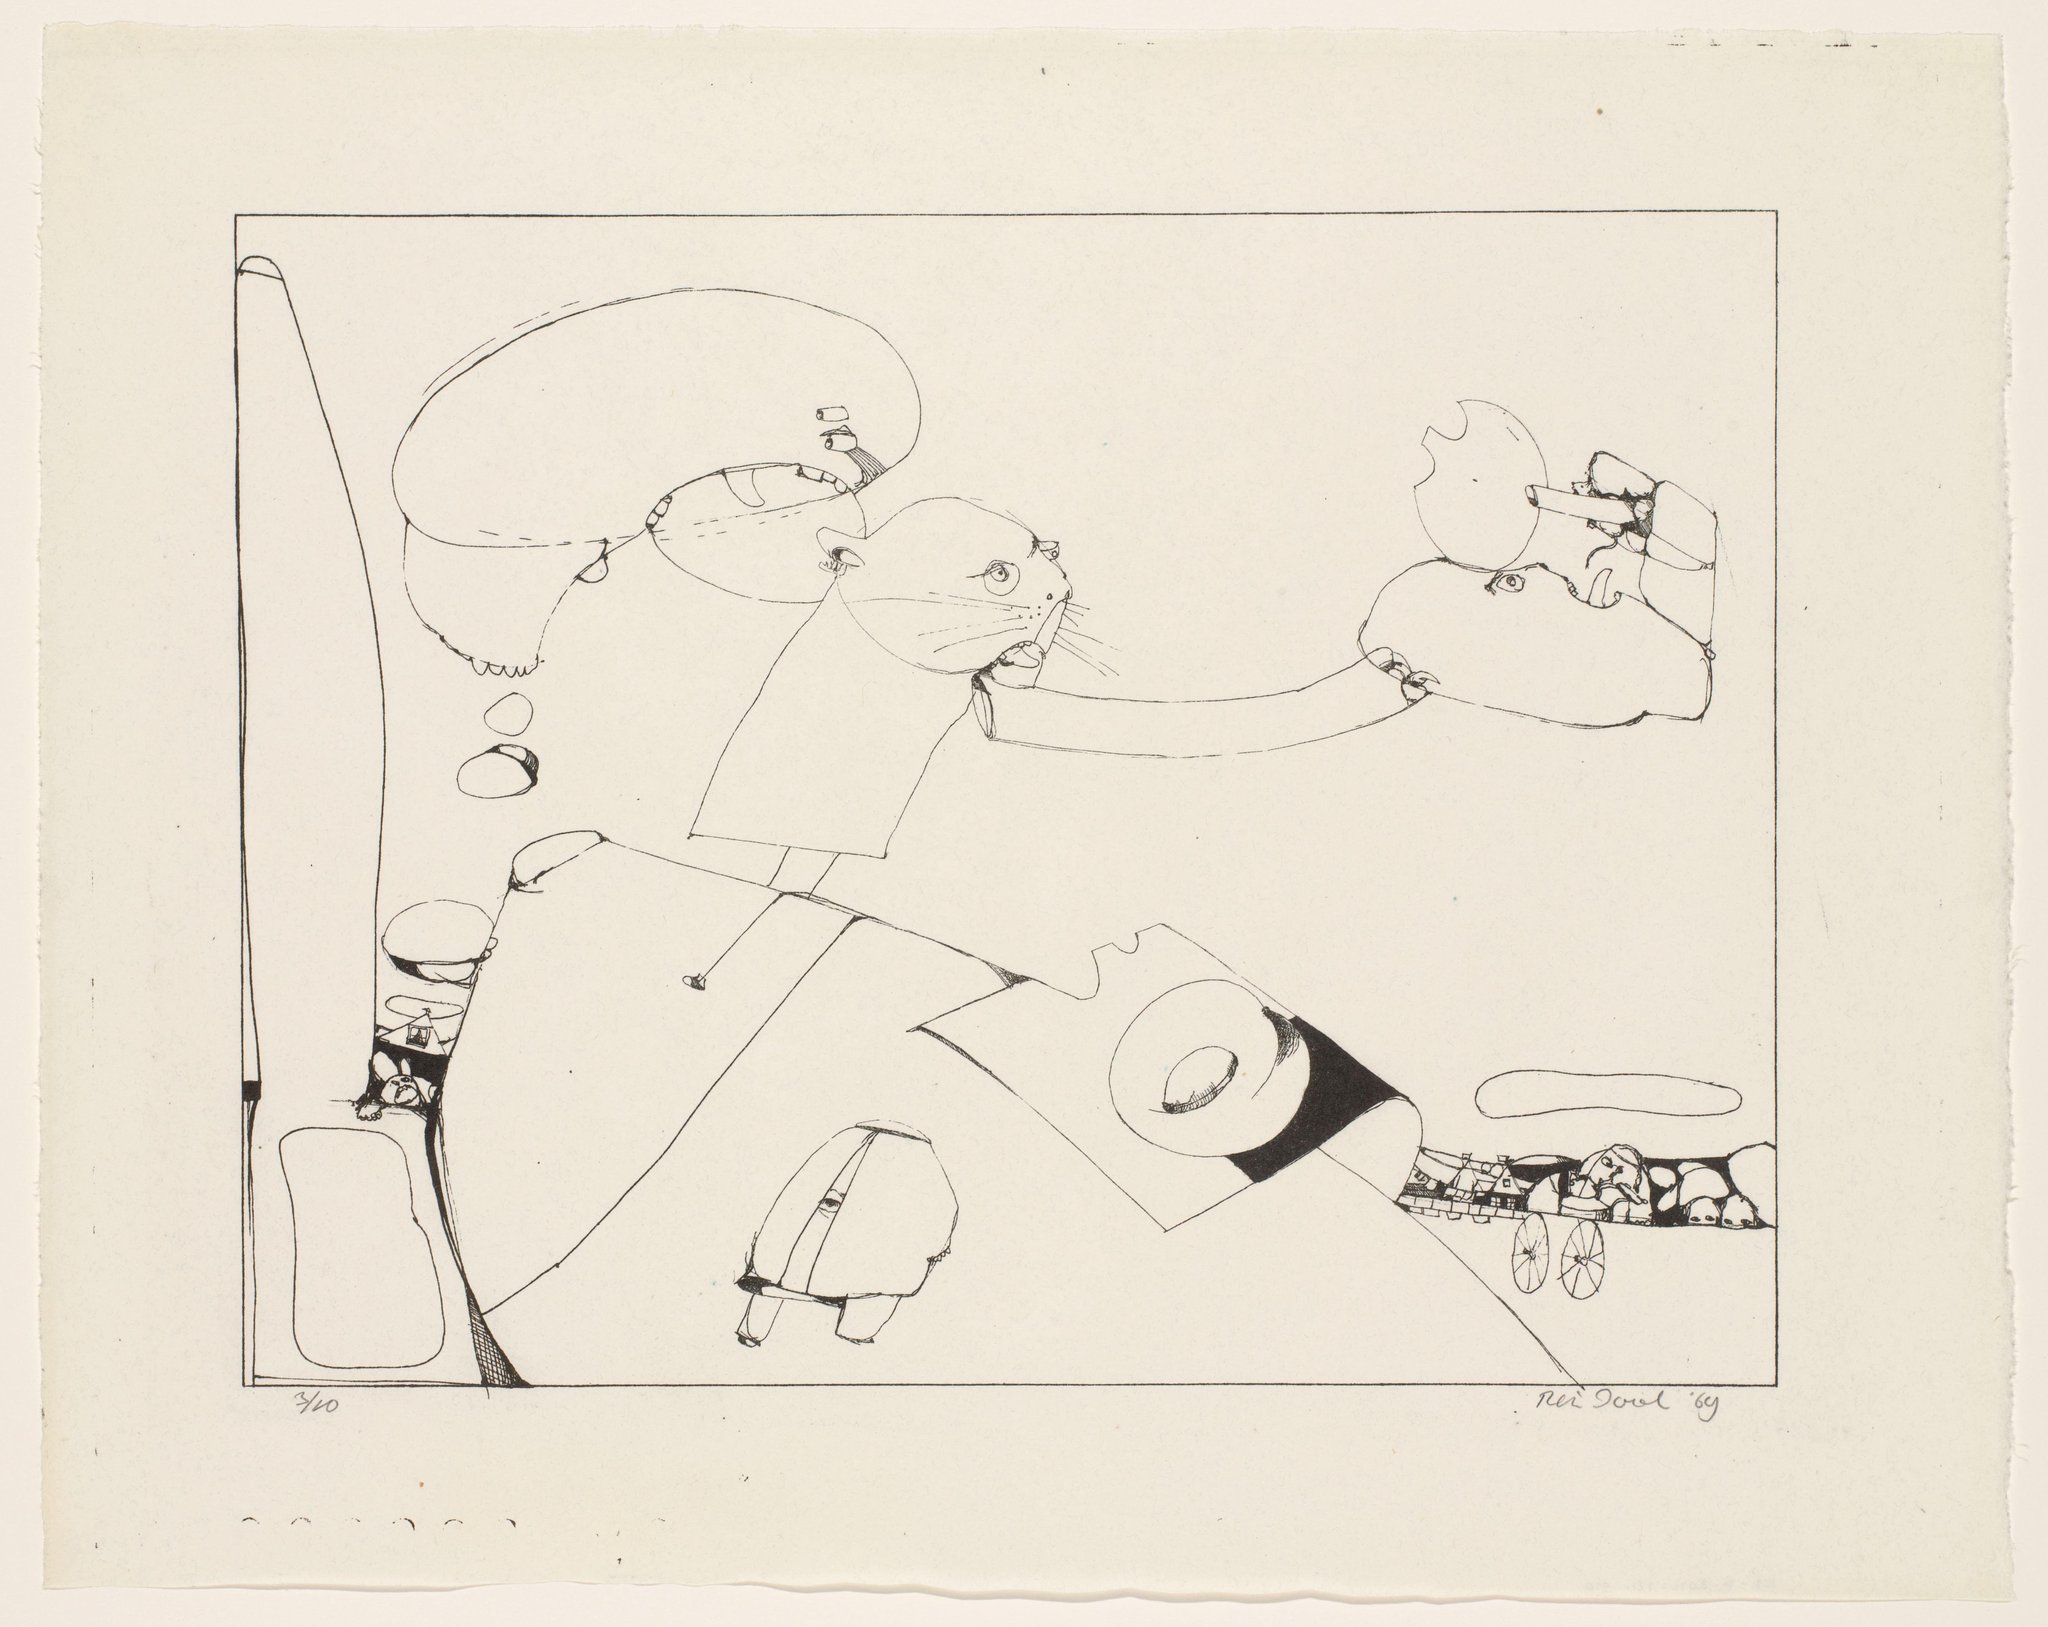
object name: print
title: Figuur met snorharen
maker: rein dool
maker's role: draughtsman, painter, print maker, sculptor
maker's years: 1933-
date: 1969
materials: paper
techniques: lithograph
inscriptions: signature and date: ‘Rein Dool '69’, edition: ‘3/10’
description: Figuur met snorharen, rechtsonder twee fietswielen.